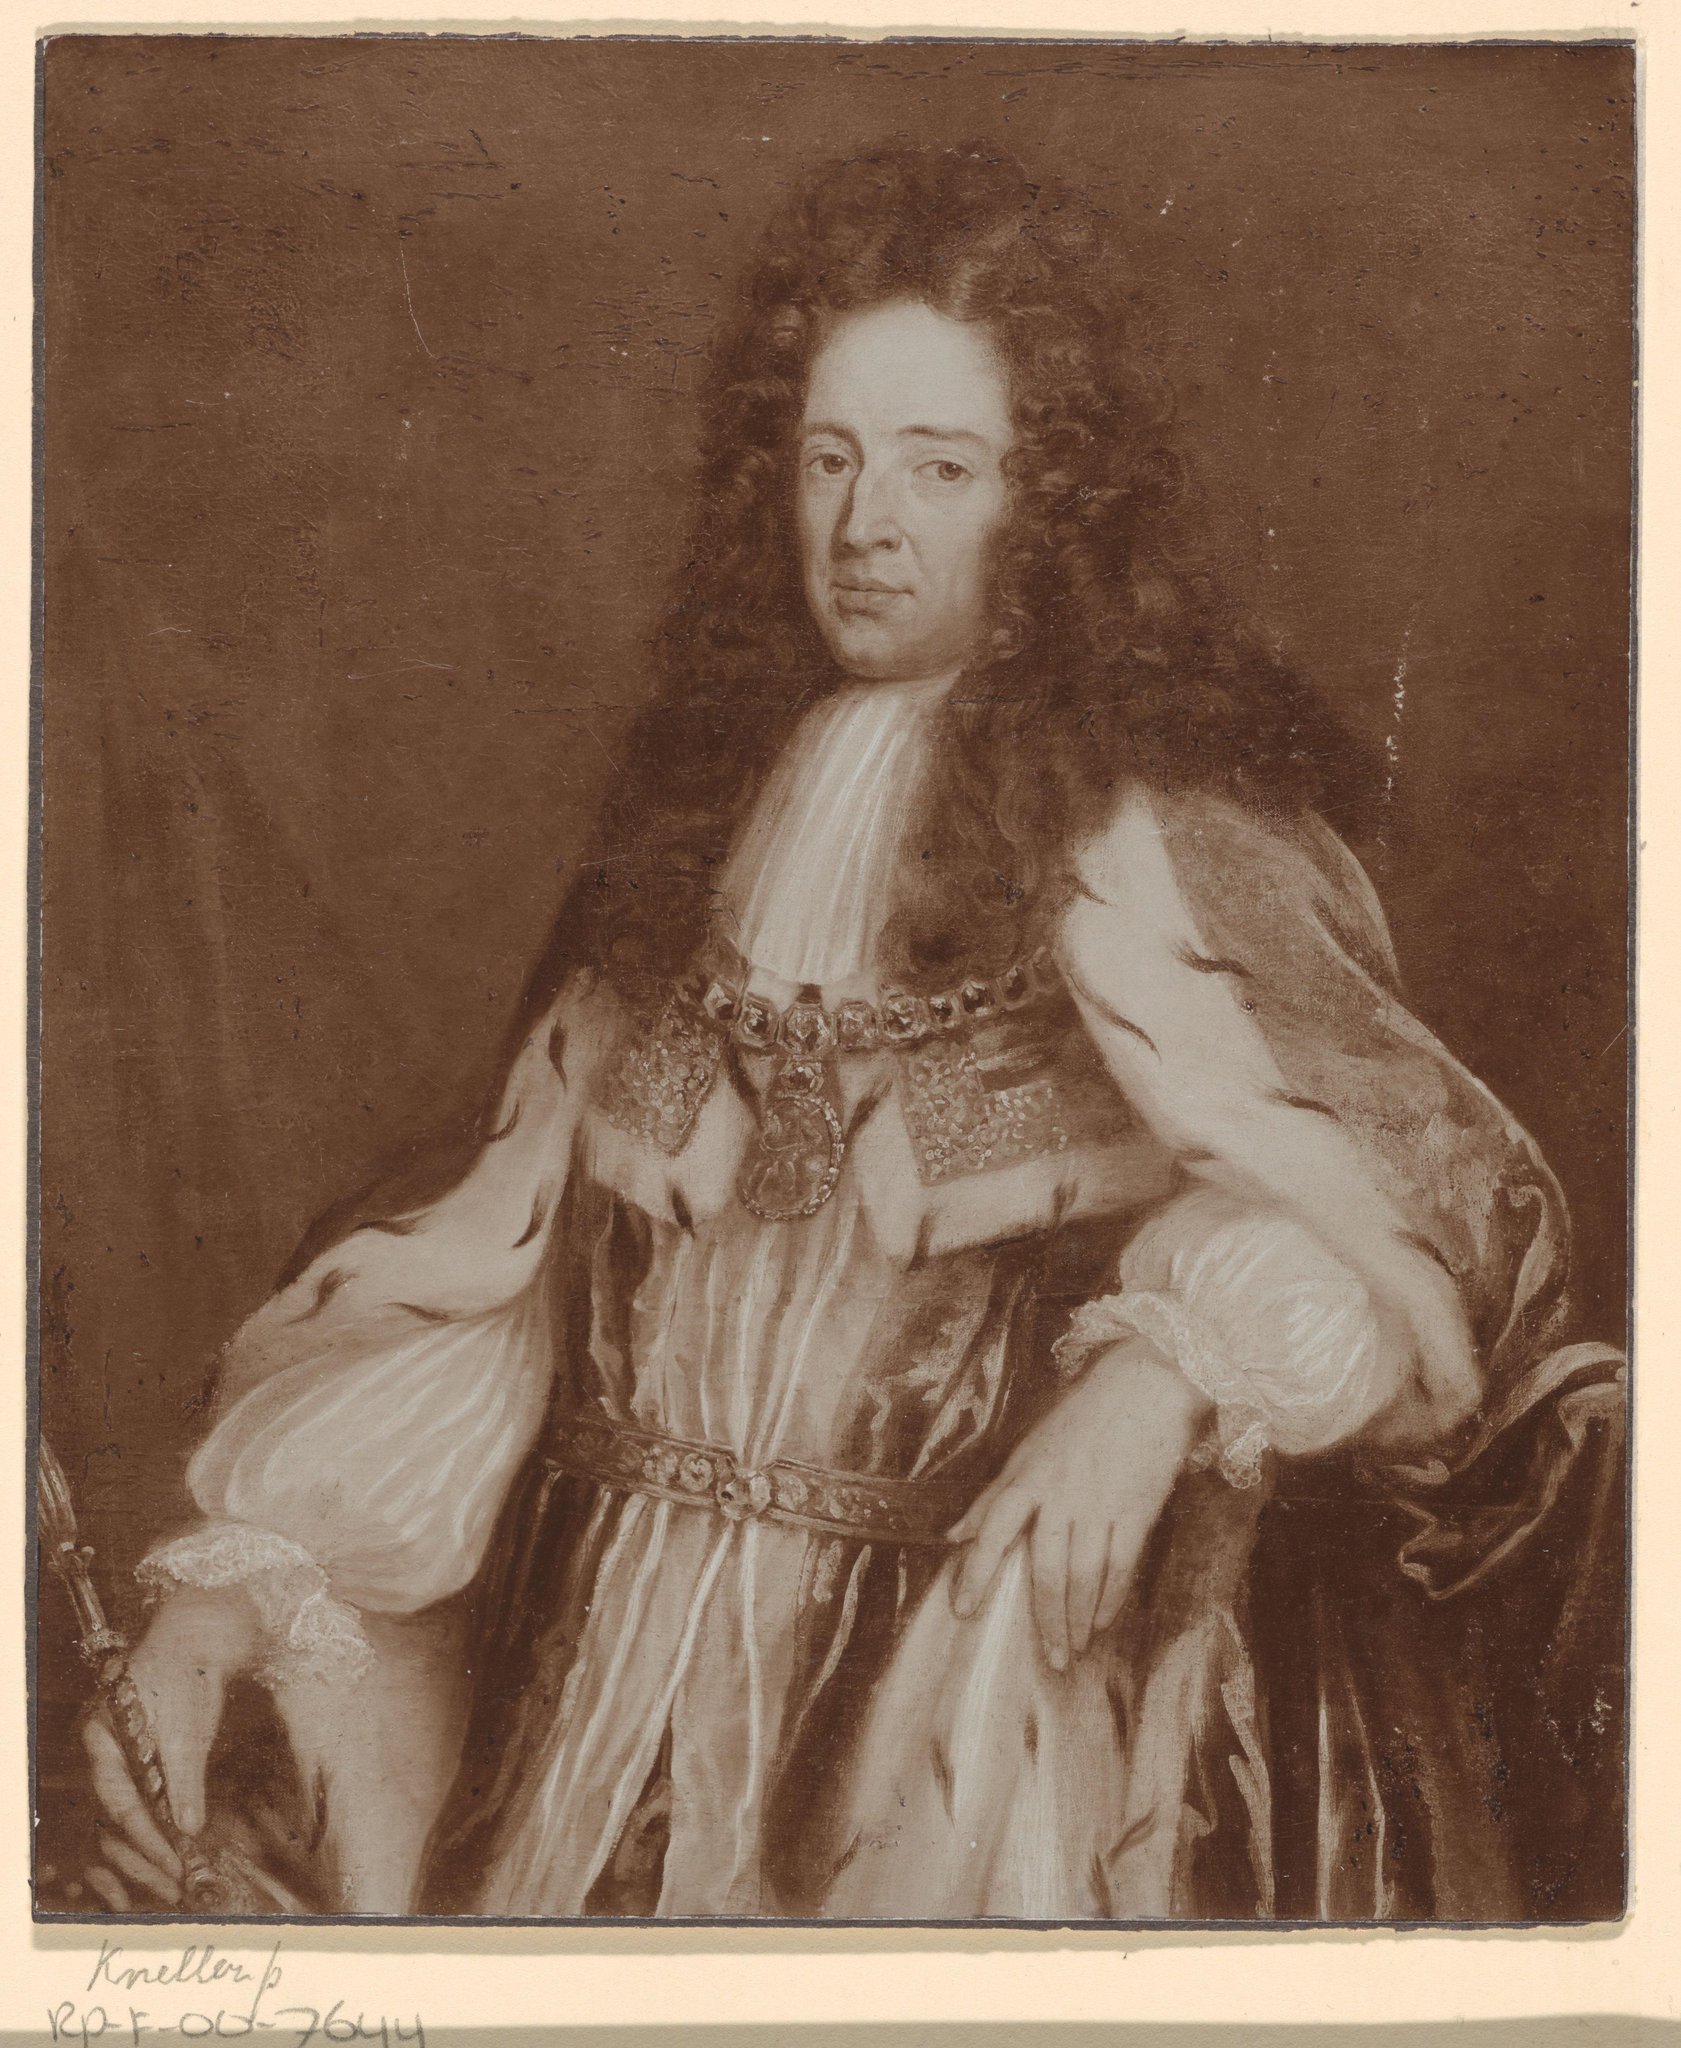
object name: photograph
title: Portret van Willem III, prins van Oranje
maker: Anonymous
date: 1850-1930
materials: photographic support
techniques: collodion silver print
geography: netherlands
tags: william iii (prince of orange and king of england, scotland, and ireland)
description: De hier vermelde titel verwijst naar de hoogst verkregen titel van de geportretteerde, niet per se naar de titel die de geportretteerde op deze voorstelling draagt.